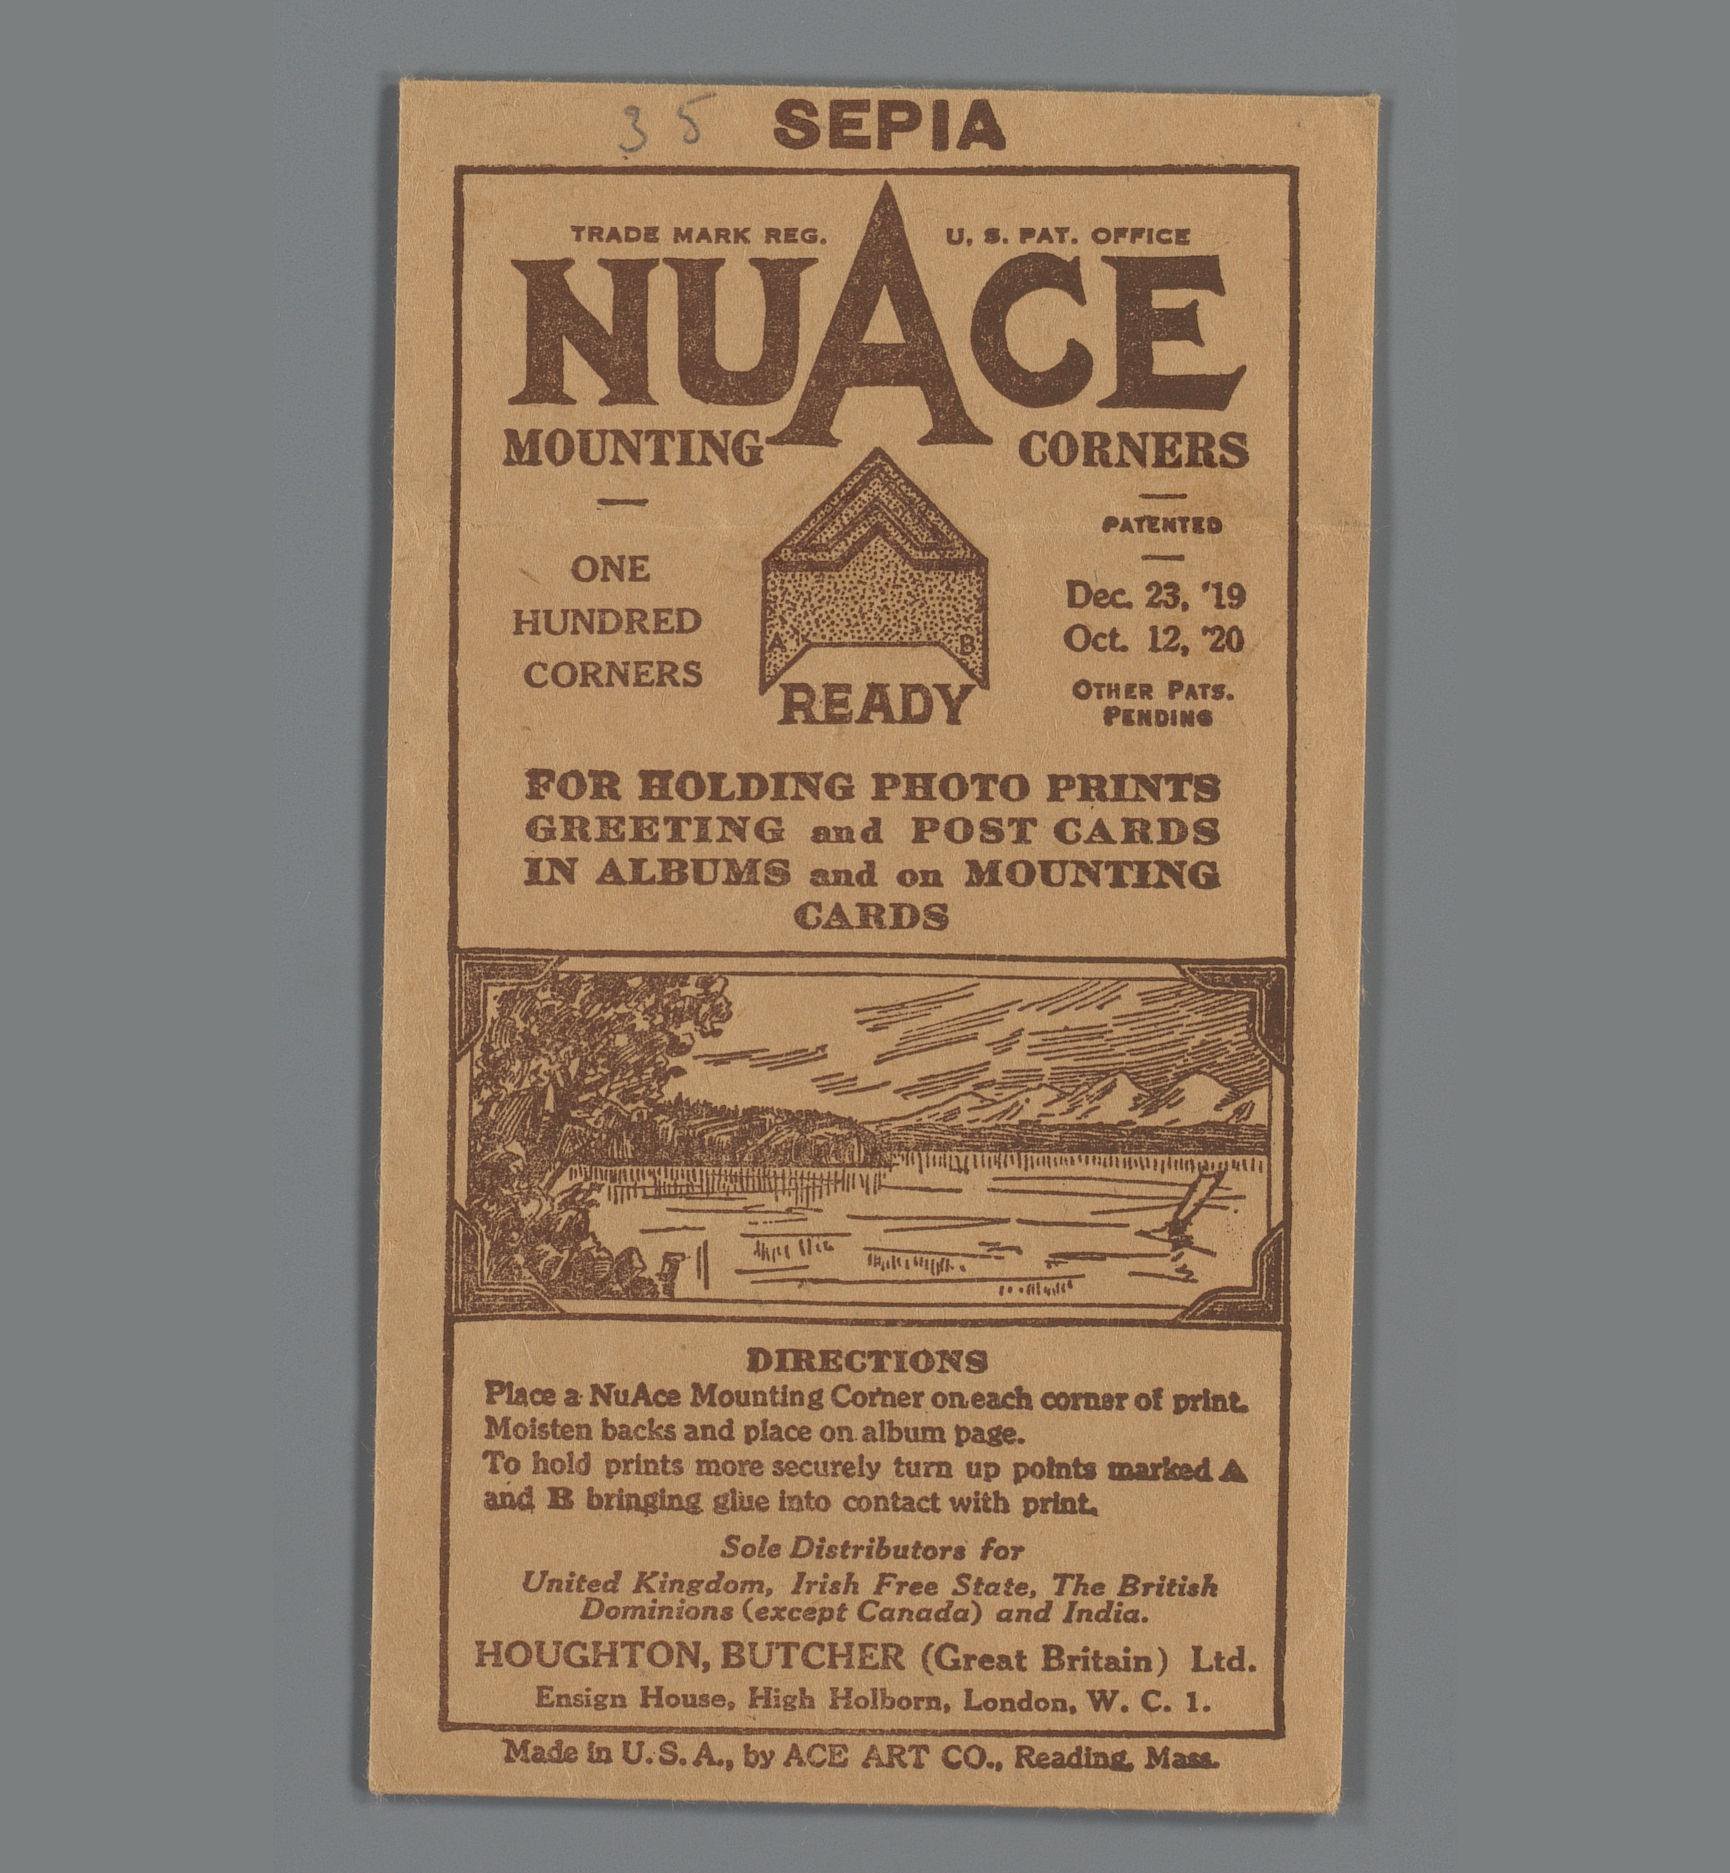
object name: document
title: Zakje met fotohoekjes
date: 1920-1940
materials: paper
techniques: lithograph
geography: reading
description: Zakje met fotohoekjes van het merk Nuace Mounting Corners, type Sepia.